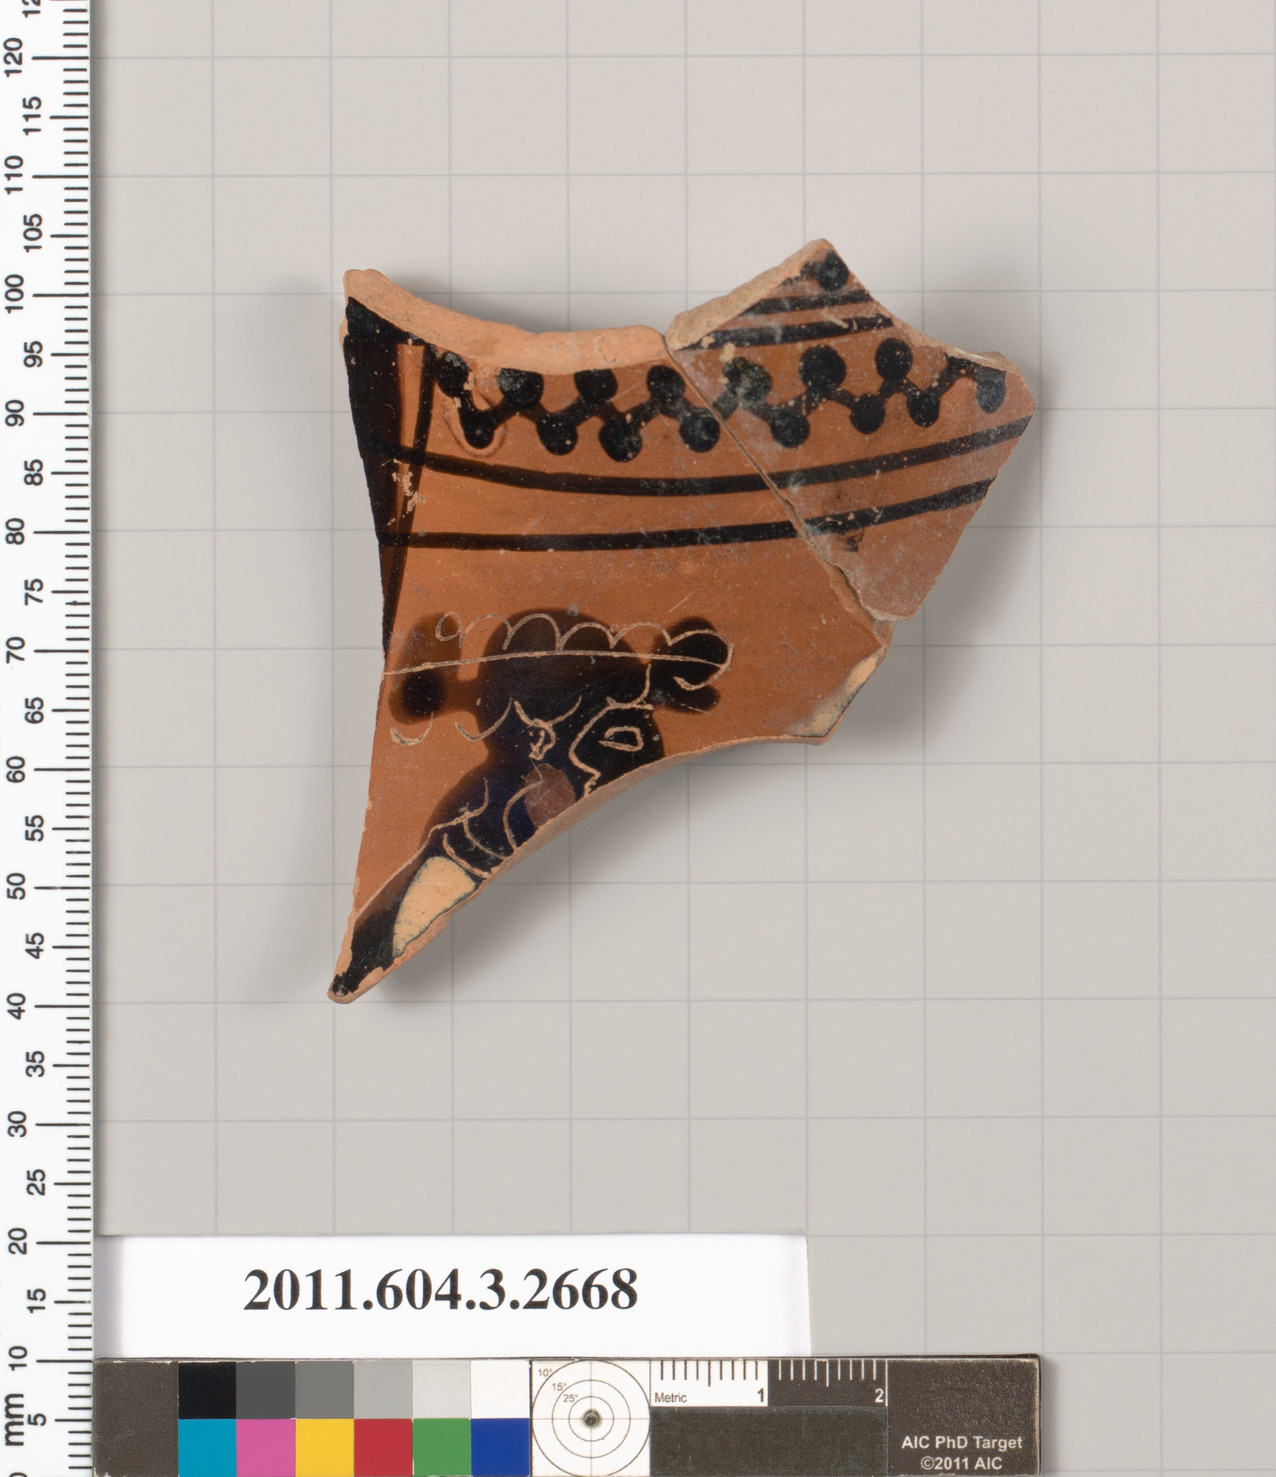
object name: olpe fragment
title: Terracotta fragment of an olpe (jug)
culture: greek, attic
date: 534-468 BCE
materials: terracotta